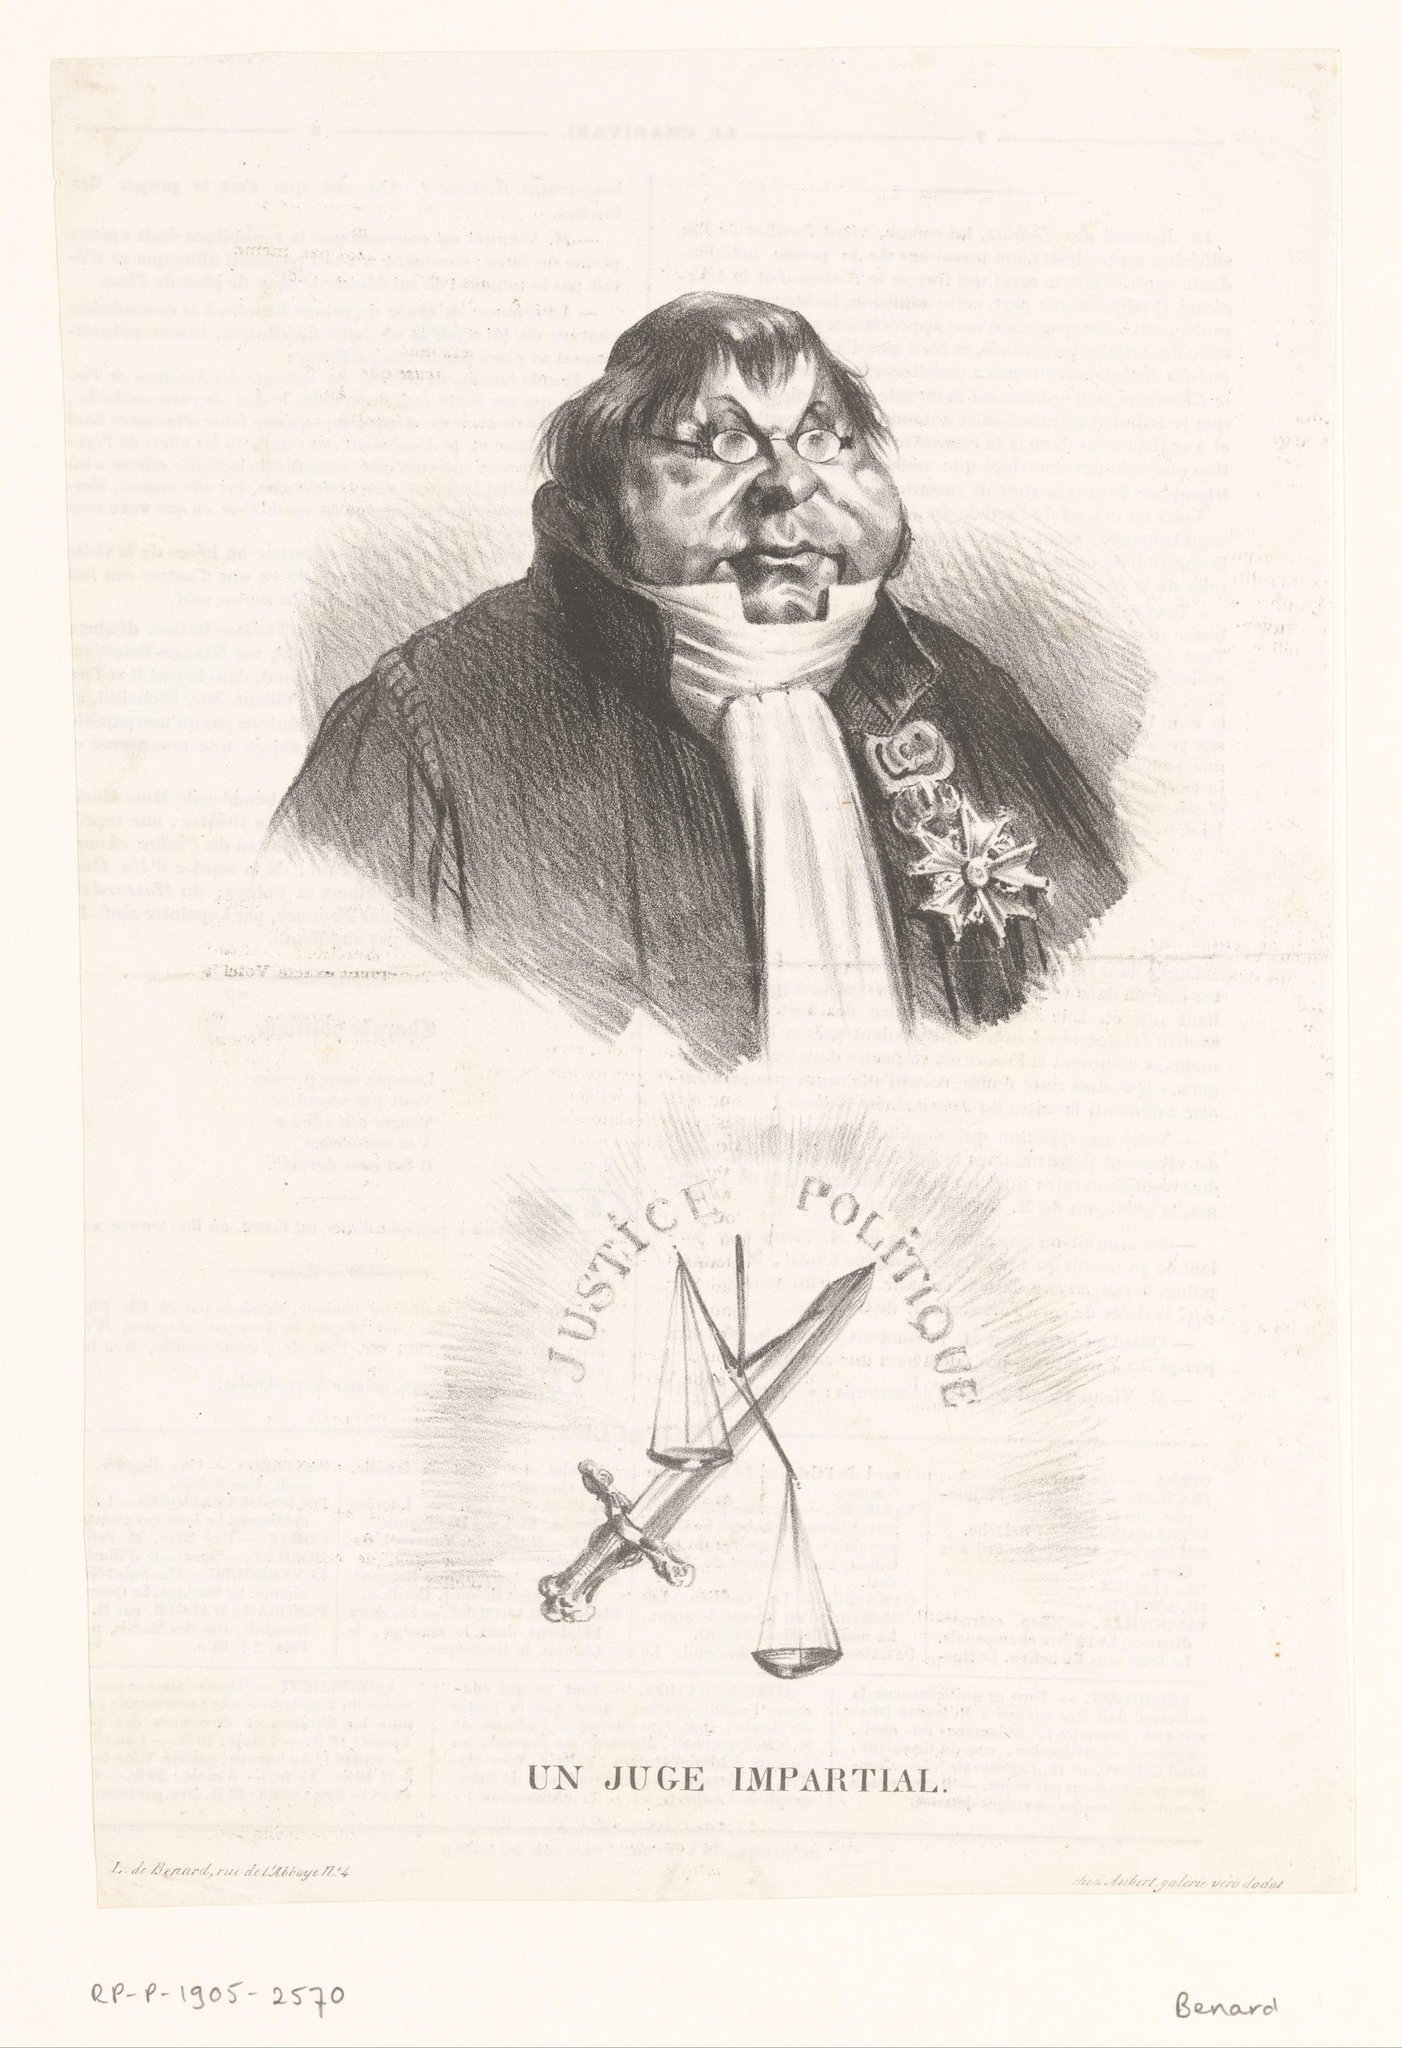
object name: cartoon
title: Karikatuur van een partijdige rechter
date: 1832-1850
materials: paper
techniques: lithograph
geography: paris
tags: bad, corrupt judge, political caricatures and satires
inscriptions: collector's mark: Lugt 2228a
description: Het zwaard van de politiek snijdt dwars door de weegschaal van de rechtspraak. Met het oordeel van de rechter zijn politieke belangen gemoeid: hij is dus niet onpartijdig.